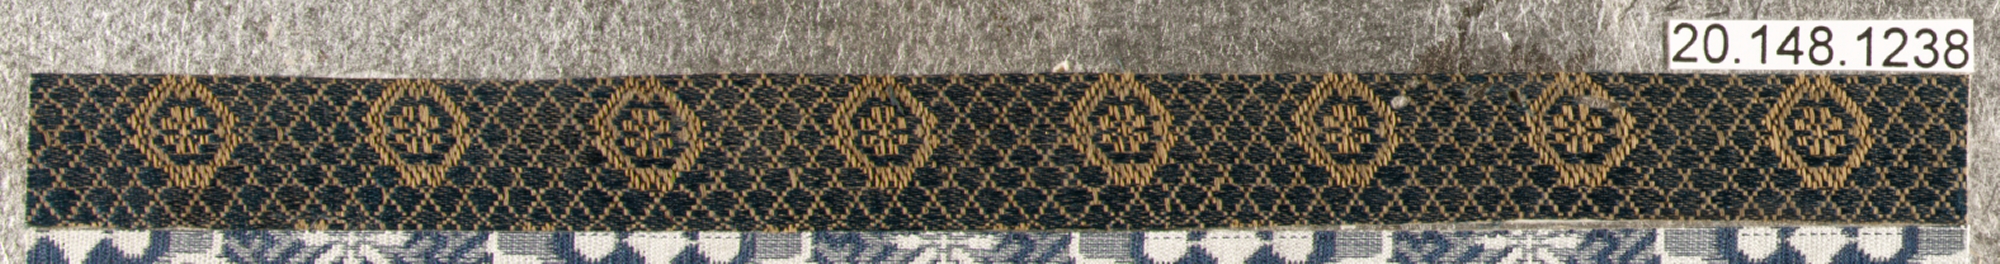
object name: piece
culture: japanese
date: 1801-1900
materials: silk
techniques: compound weave